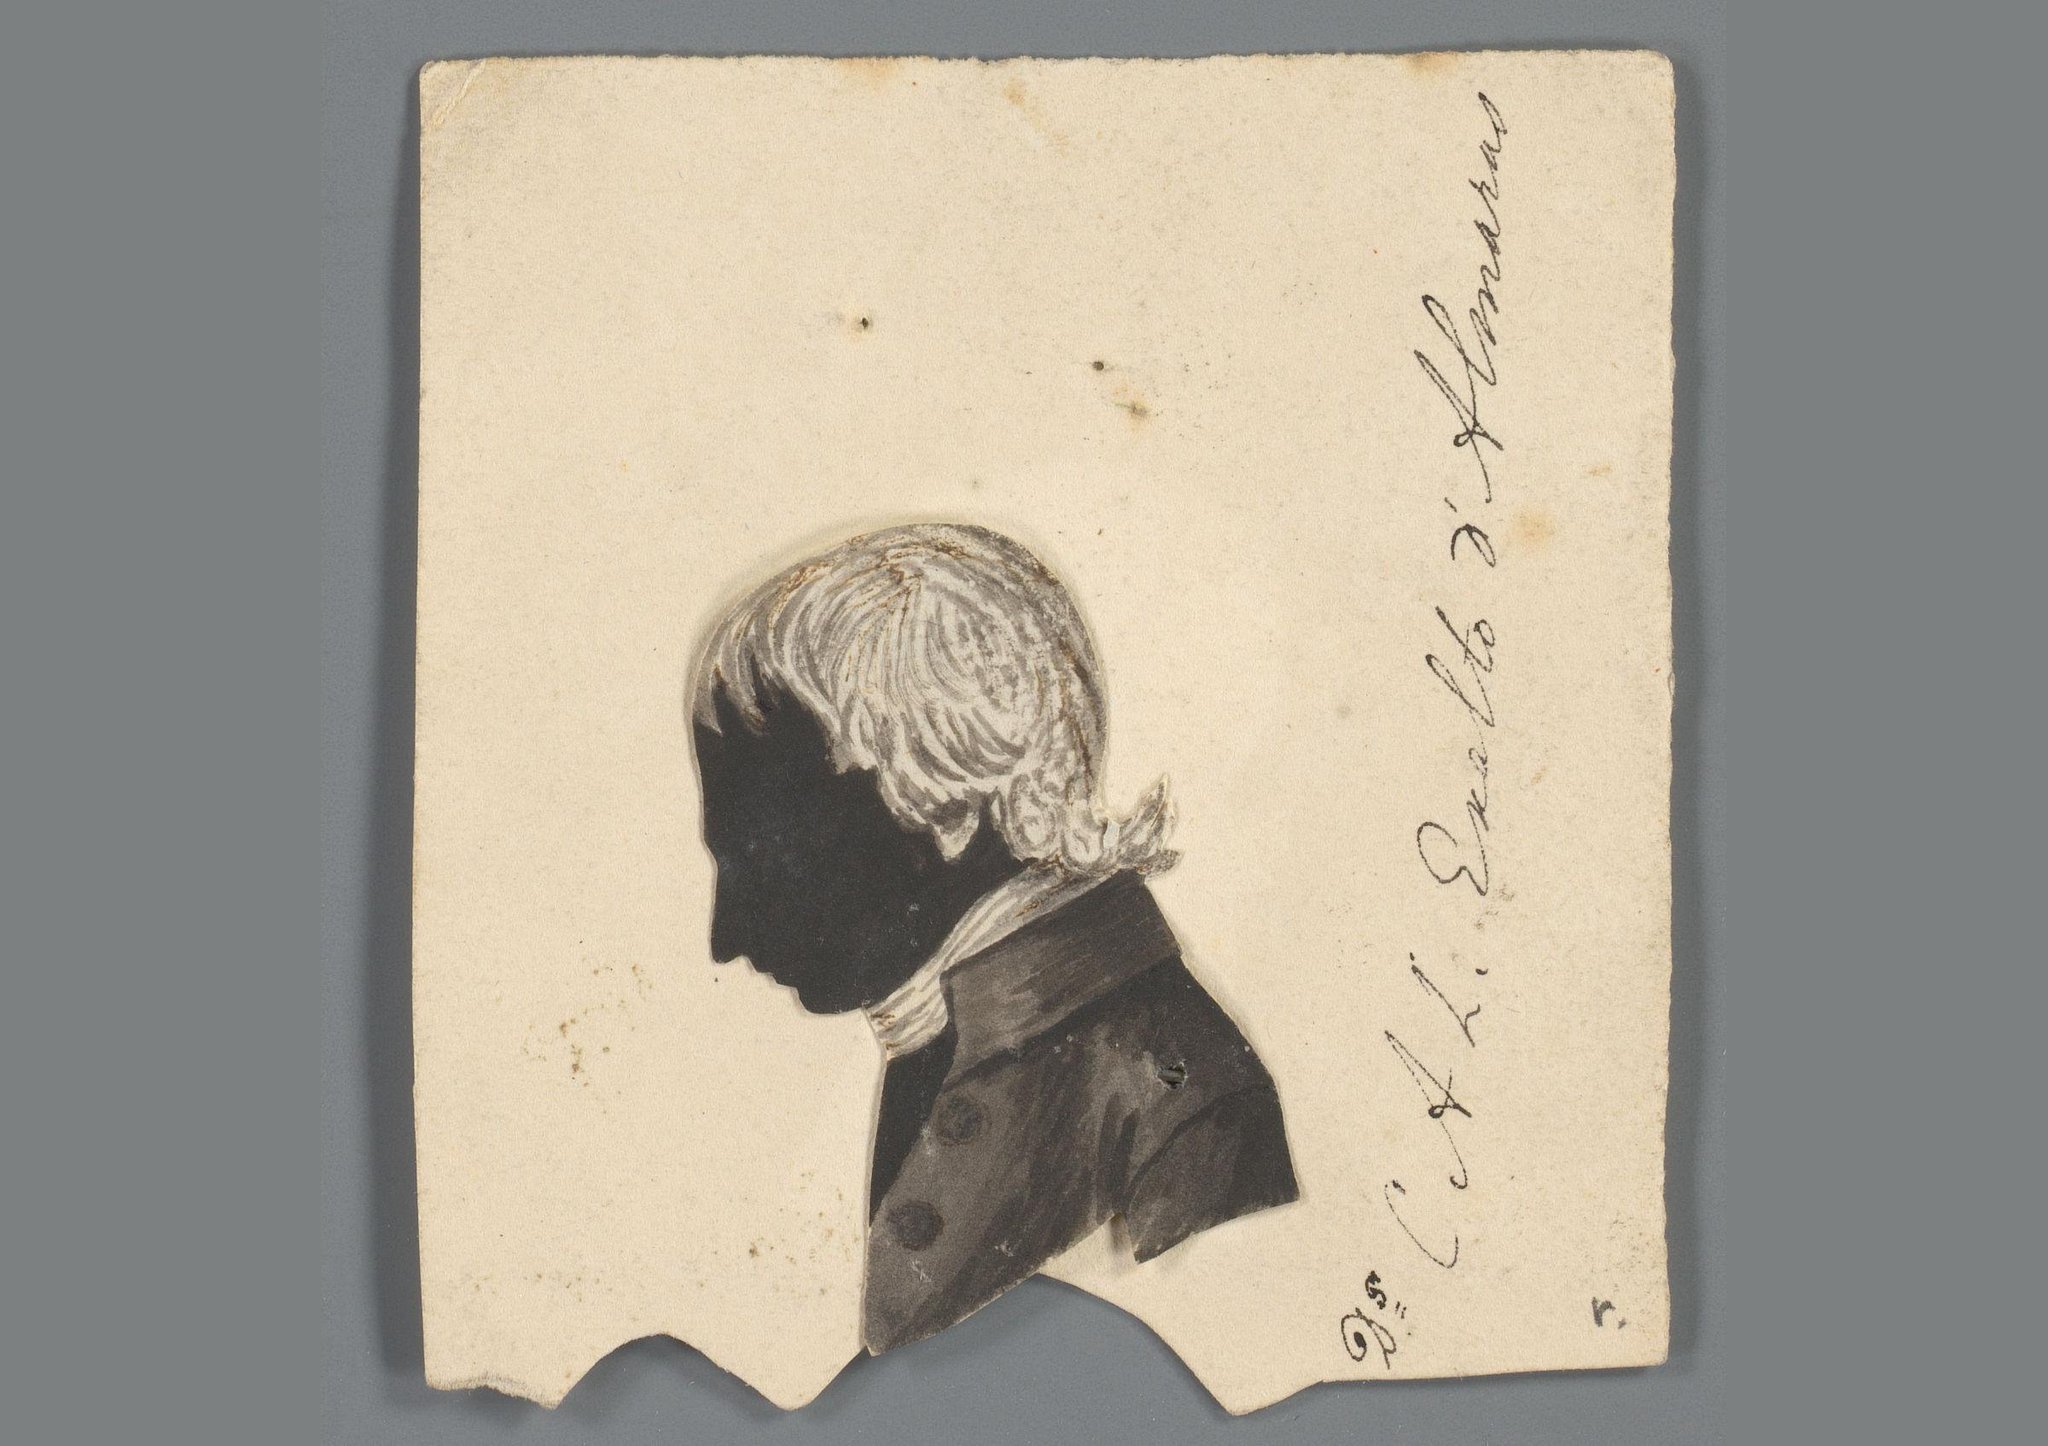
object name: cut paper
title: Silhouet van een jongeman, Ds. C.A.L. Exalto d'Almaras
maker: Anonymous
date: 1700-1900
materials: paper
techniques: brush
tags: historical persons, male sex; man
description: Silhouet van een jongeman vastgespeld samen met een ander silhouet verso aan een papiertje, met tekst: Ds. C.A.L. Exalto d'Almaras